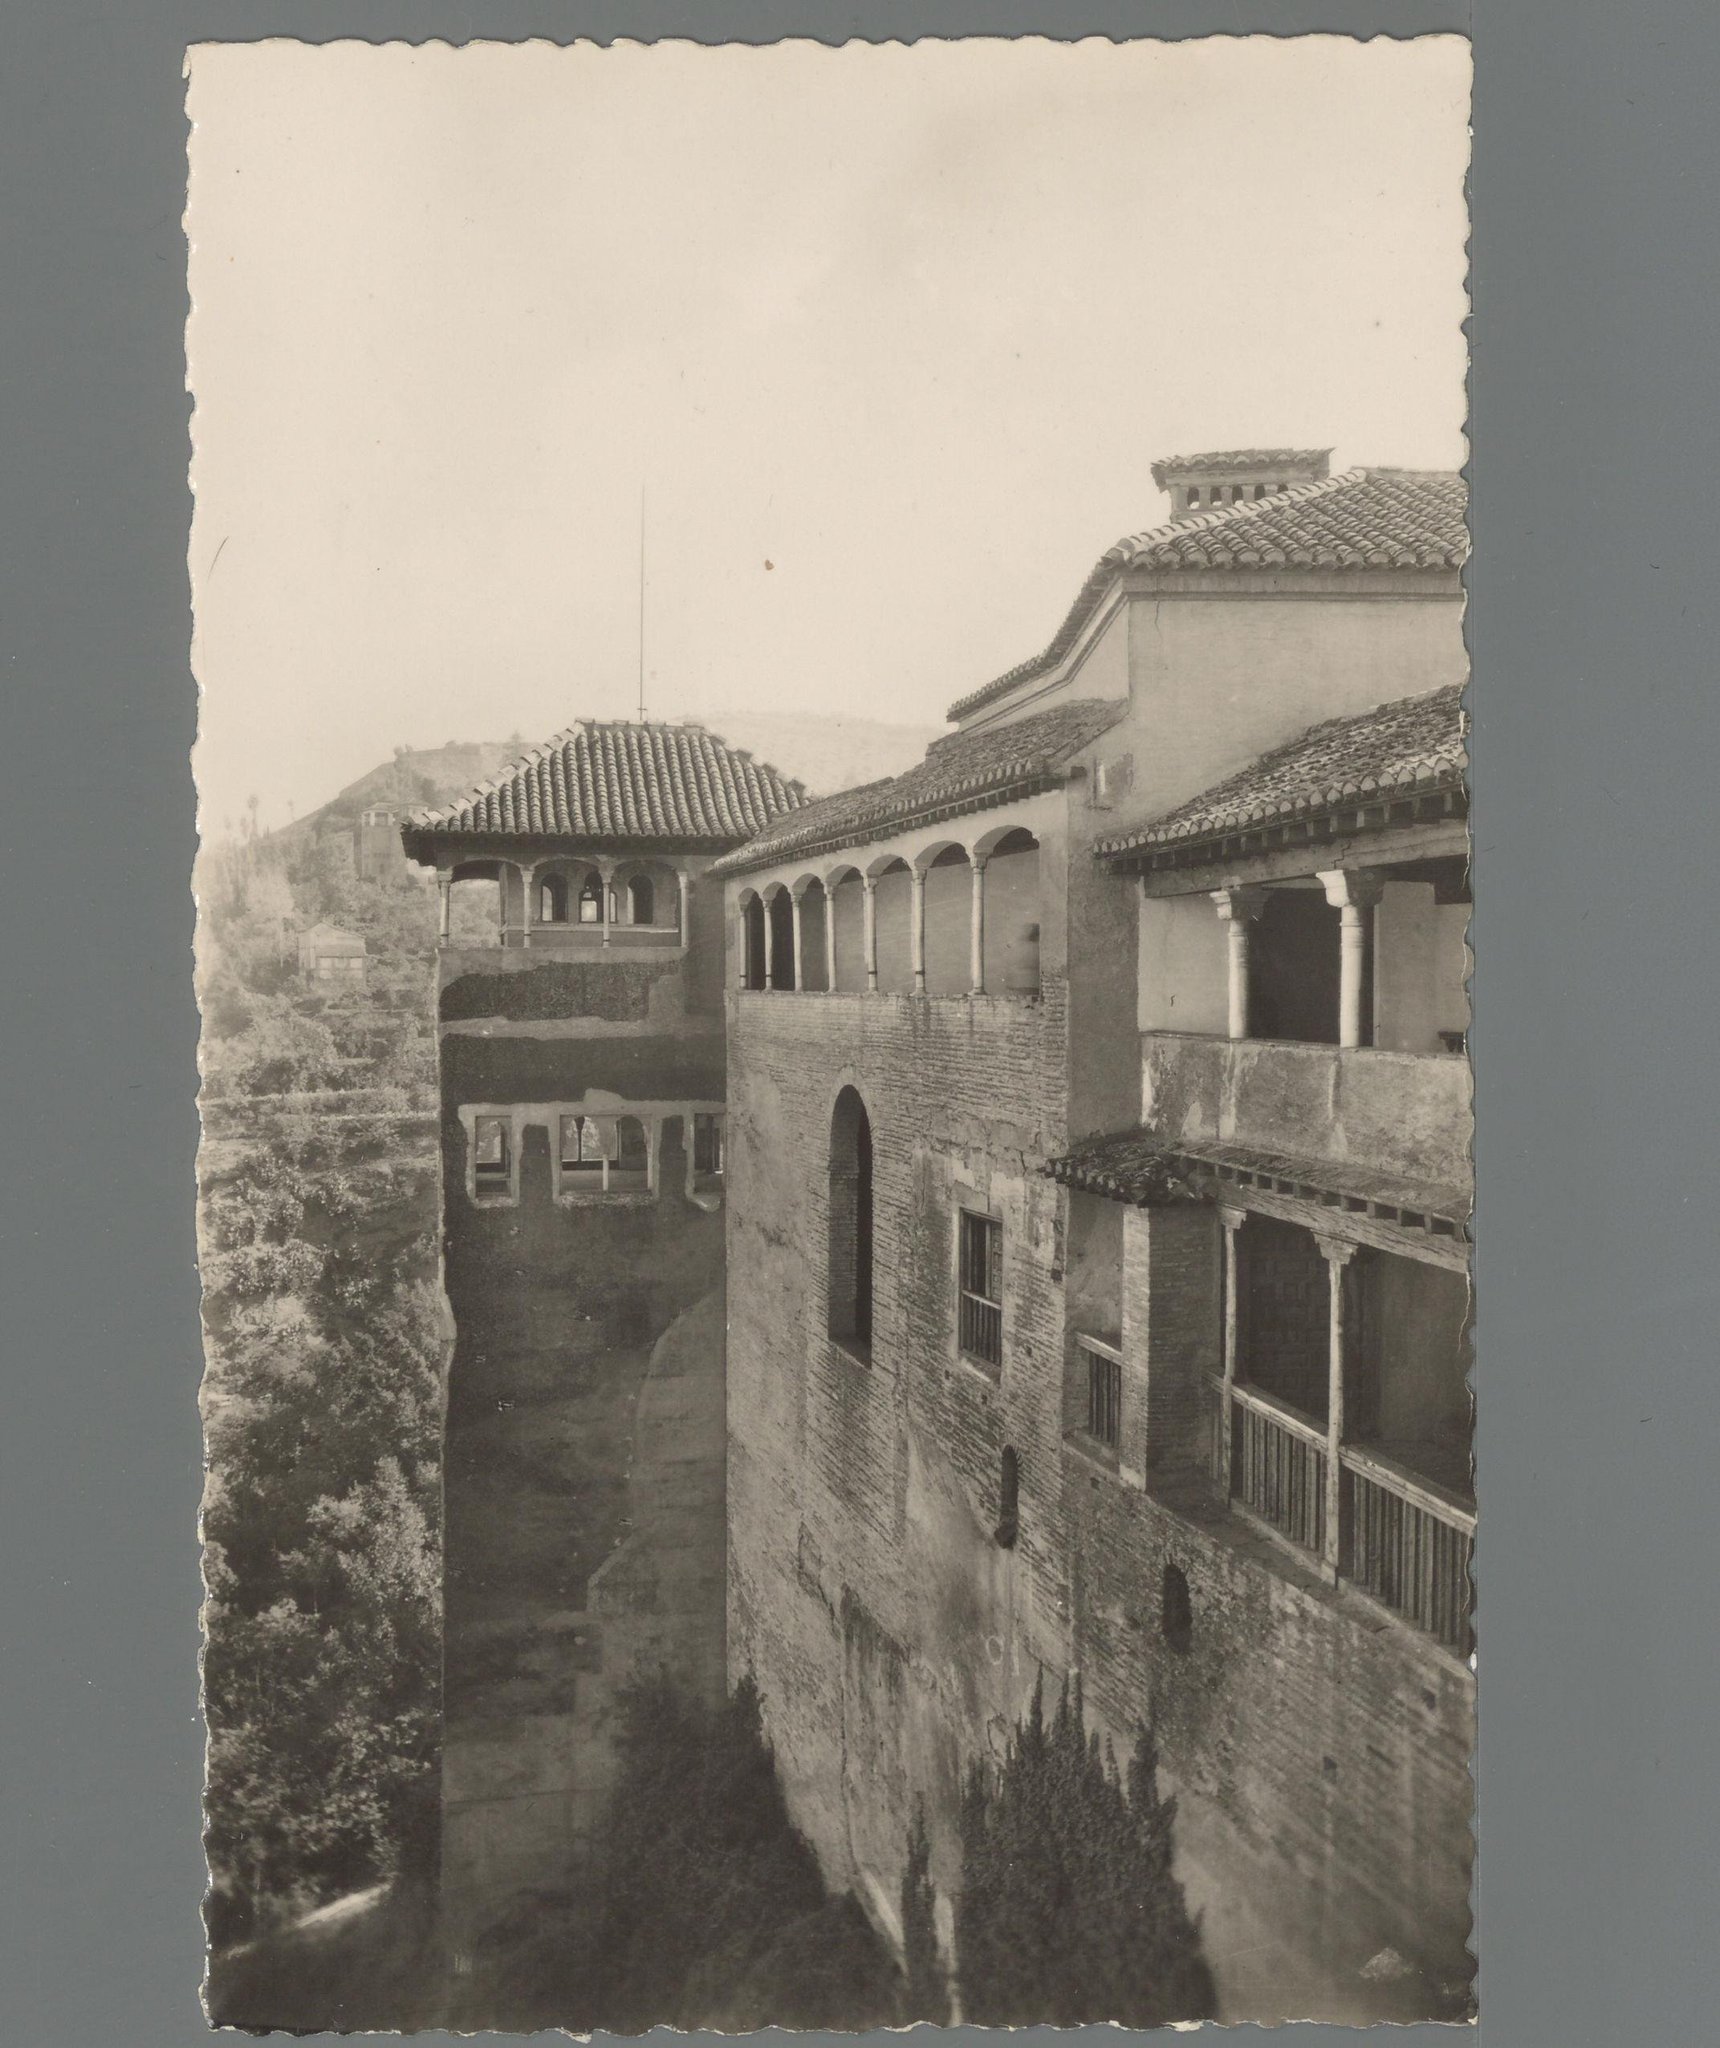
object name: photograph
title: Granada - Alhambra: Peinador de la Reina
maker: Anonymous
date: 1918-1930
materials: paper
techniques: gelatin silver print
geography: granada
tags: palace